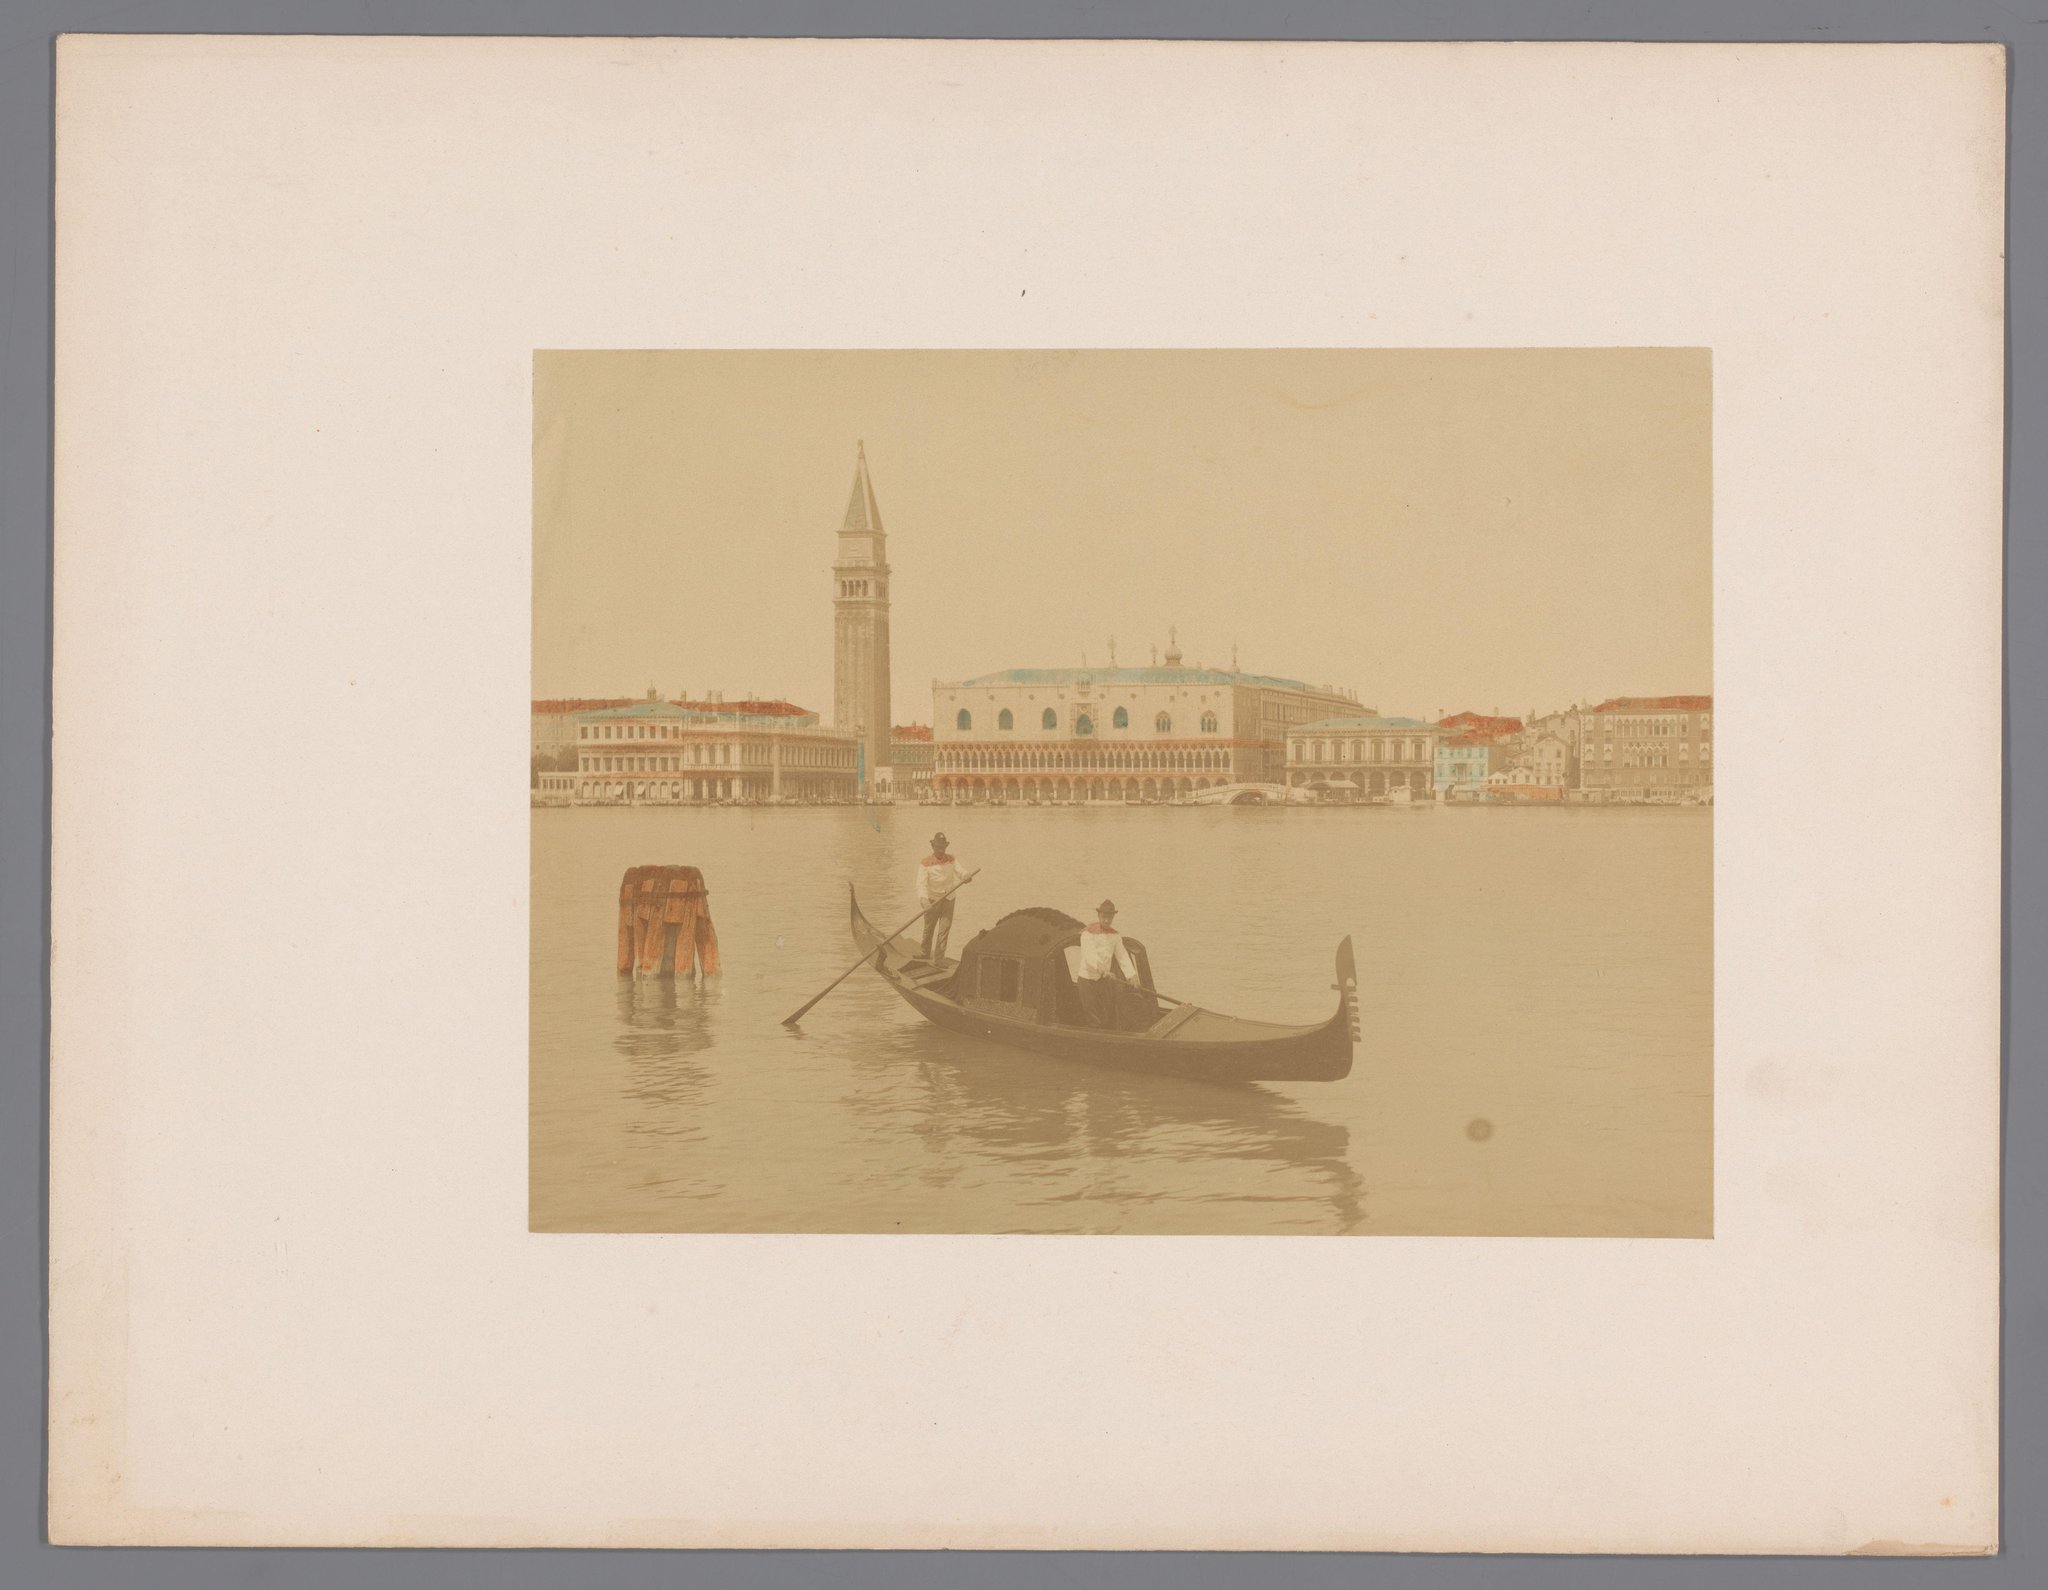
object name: photograph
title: Gezicht op het Dogepaleis en de Campanile en op de voorgrond een gondel te Venetië, Italië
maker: Anonymous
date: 1851-1900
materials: cardboard, paper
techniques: albumen print, hand coloring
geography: venice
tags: parts of church exterior and annexes: campanile, palace, gondola